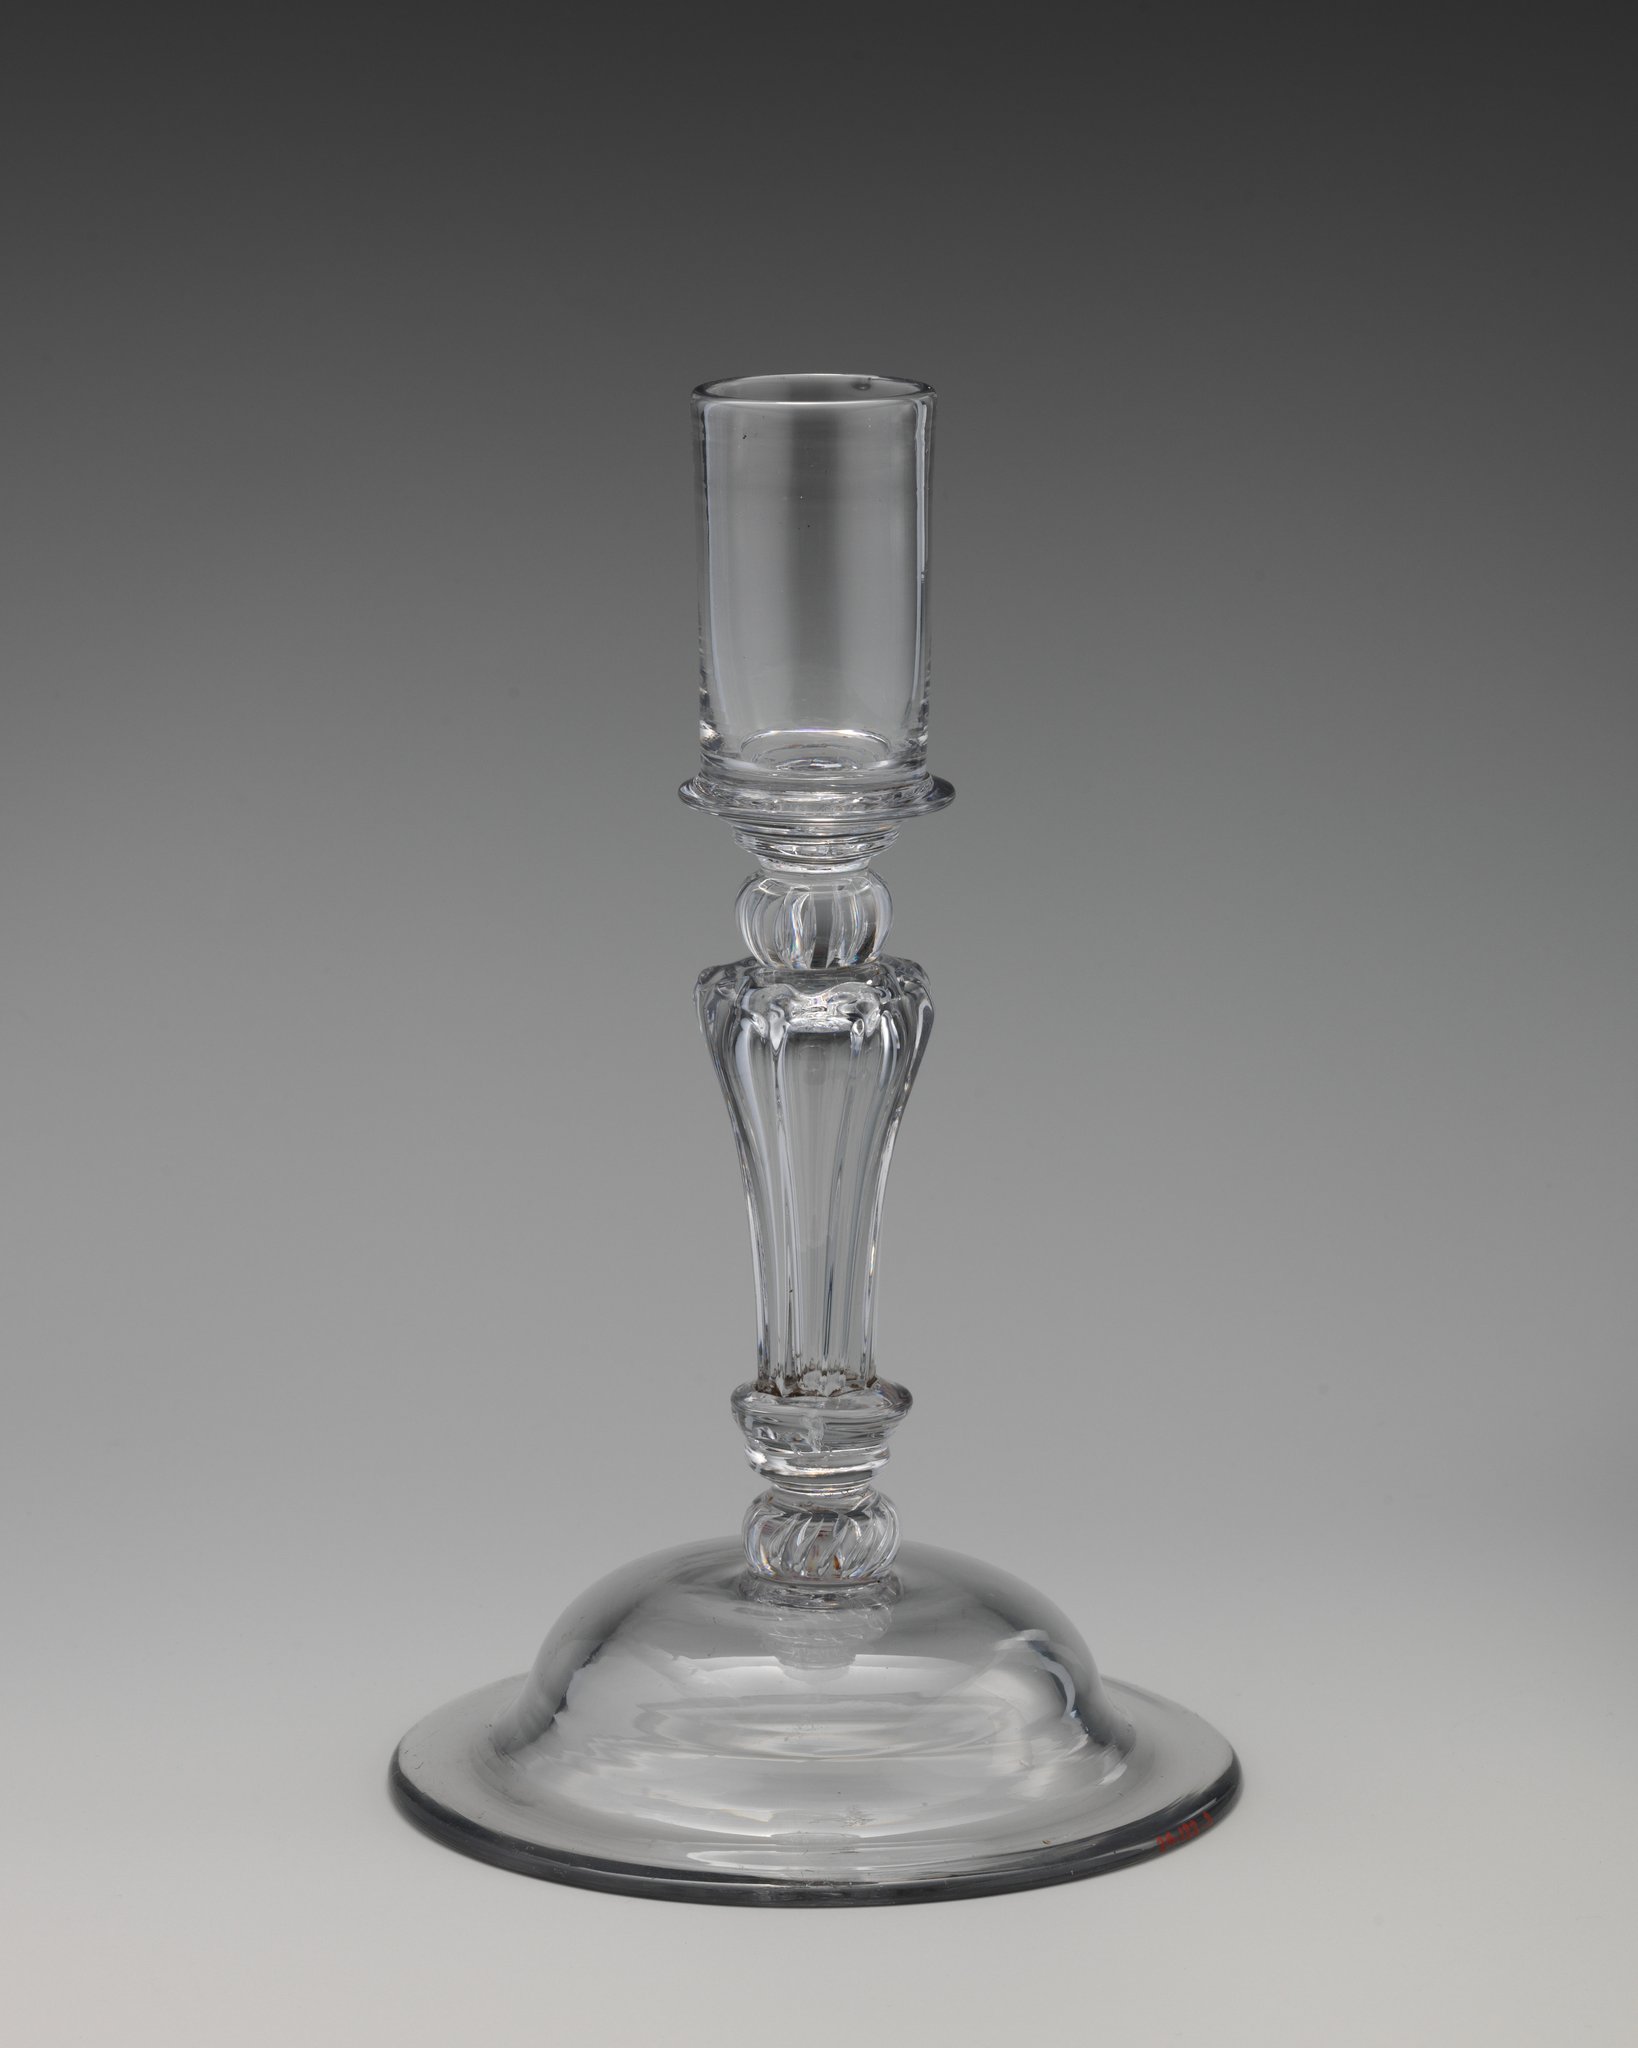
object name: candlestick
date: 1740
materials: glass